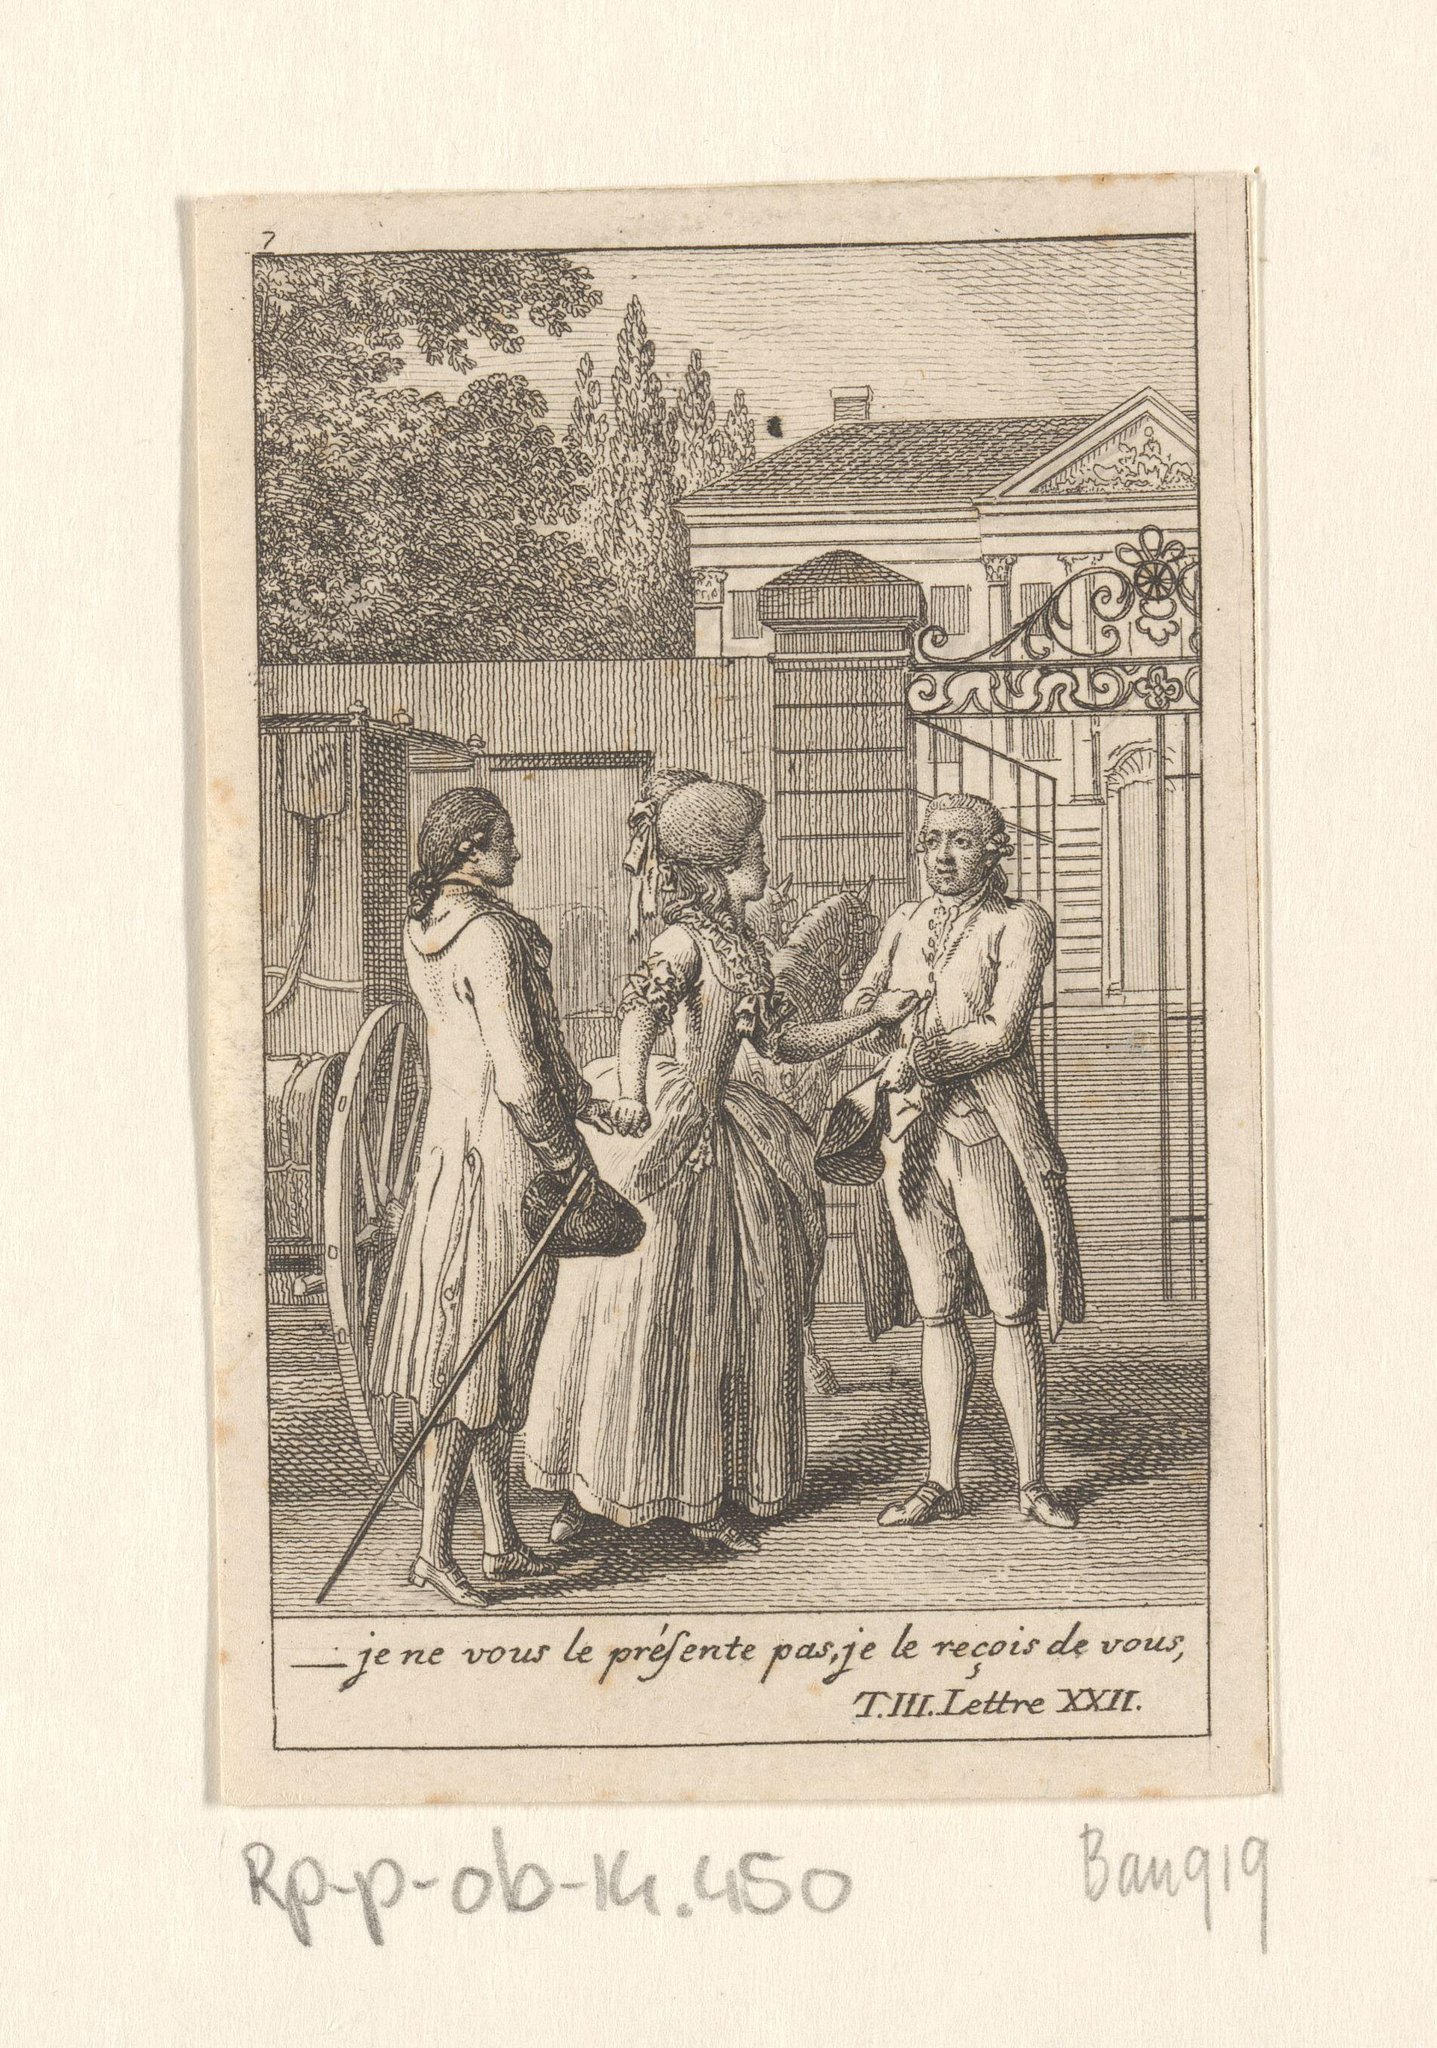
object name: print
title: Julie ontmoet St. Preux na zijn wereldreis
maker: daniel nikolaus chodowiecki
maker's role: draughtsman, print maker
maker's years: 1726-1801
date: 1782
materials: paper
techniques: etching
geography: berlin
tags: four-wheeled, animal-drawn vehicle, e.g.: cab, carriage, coach, gate, entrance, villa, lovers' meeting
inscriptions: collector's mark: Lugt 2228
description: Vervaardigd voor Jean-Jacques Rousseaus 'Neue Héliose'. Latere staat gebruikt voor: Almanac généalogique pour l'année 1783. Berlijn: s.n., 1782.